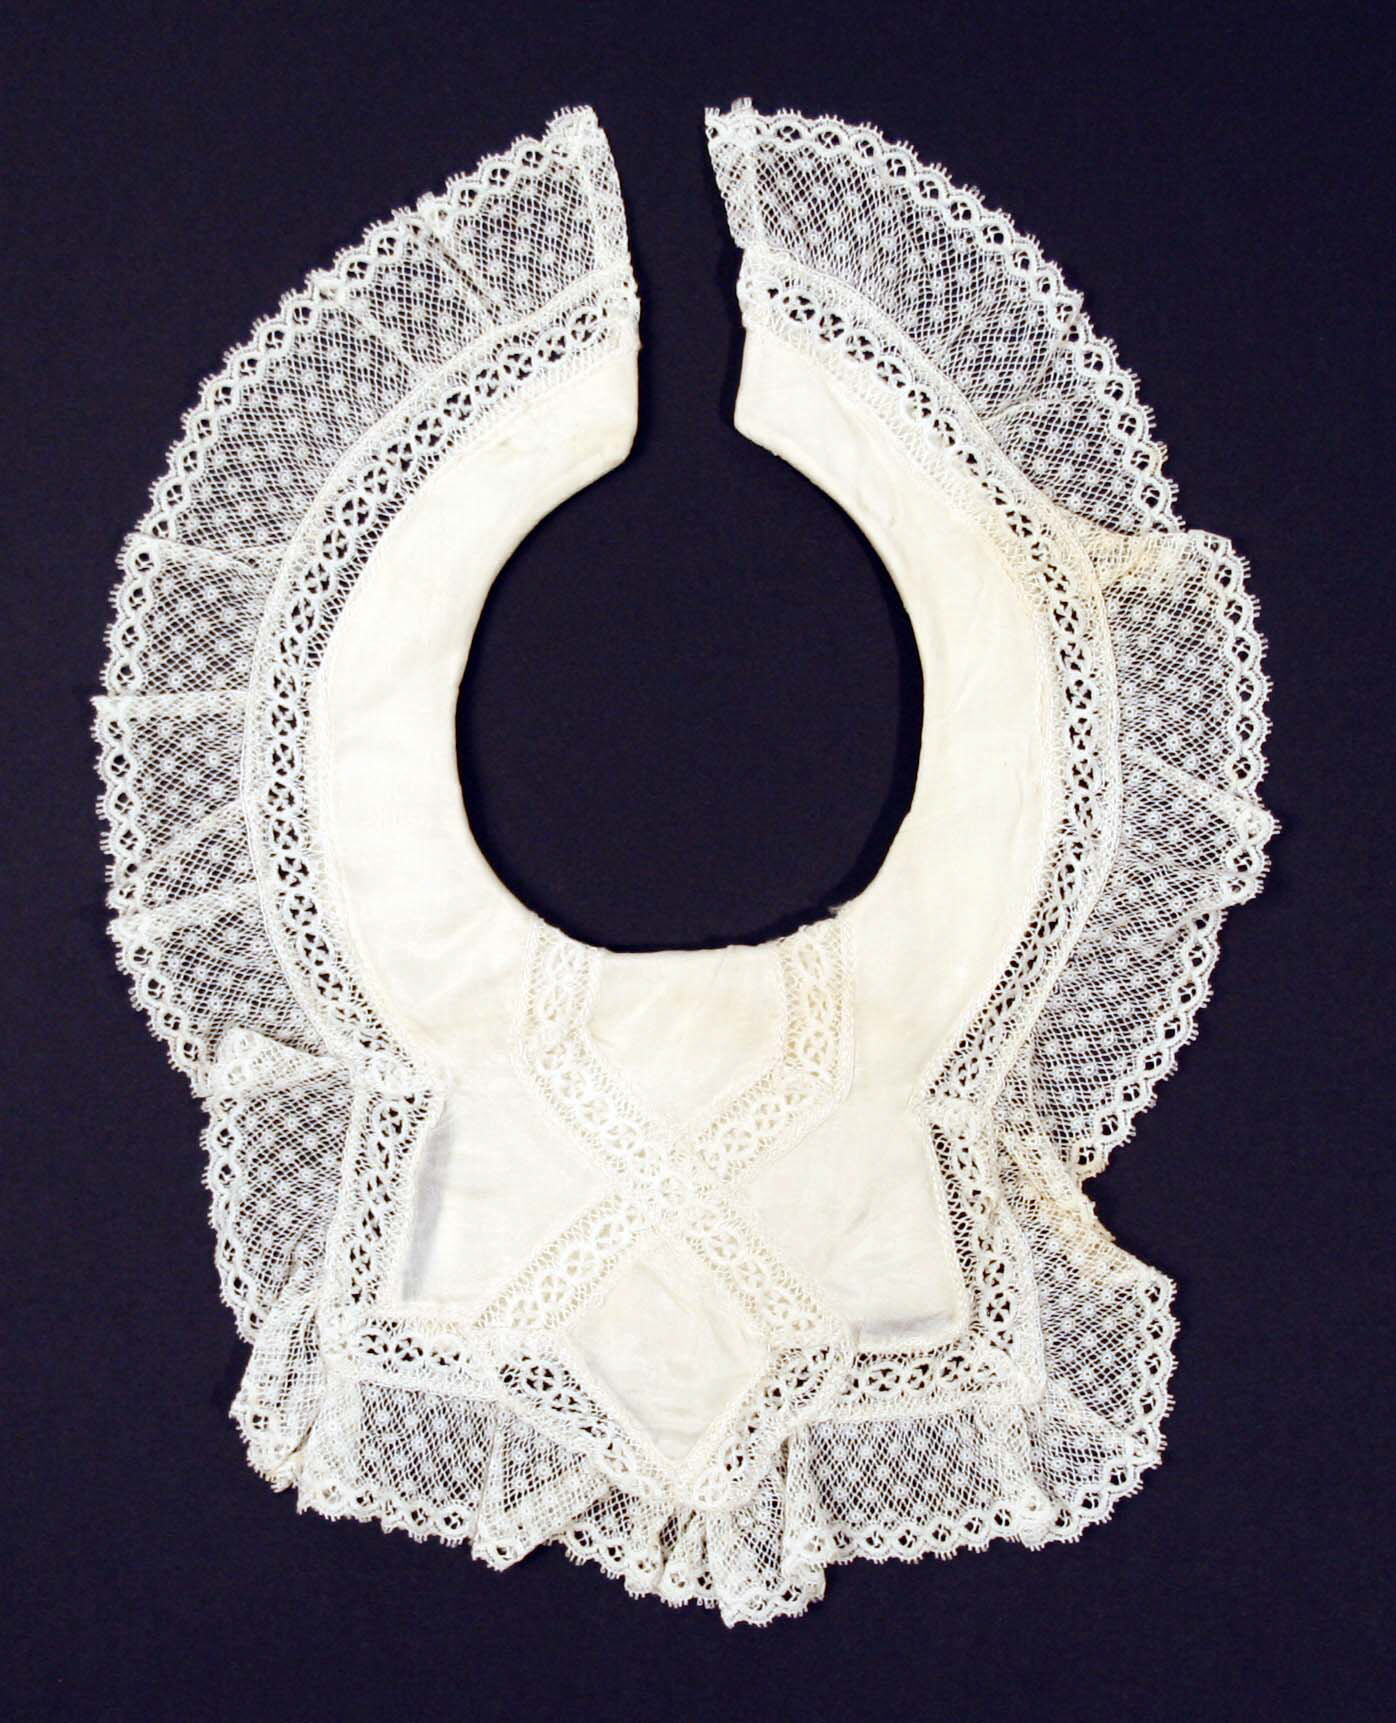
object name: bib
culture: american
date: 1880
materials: silk